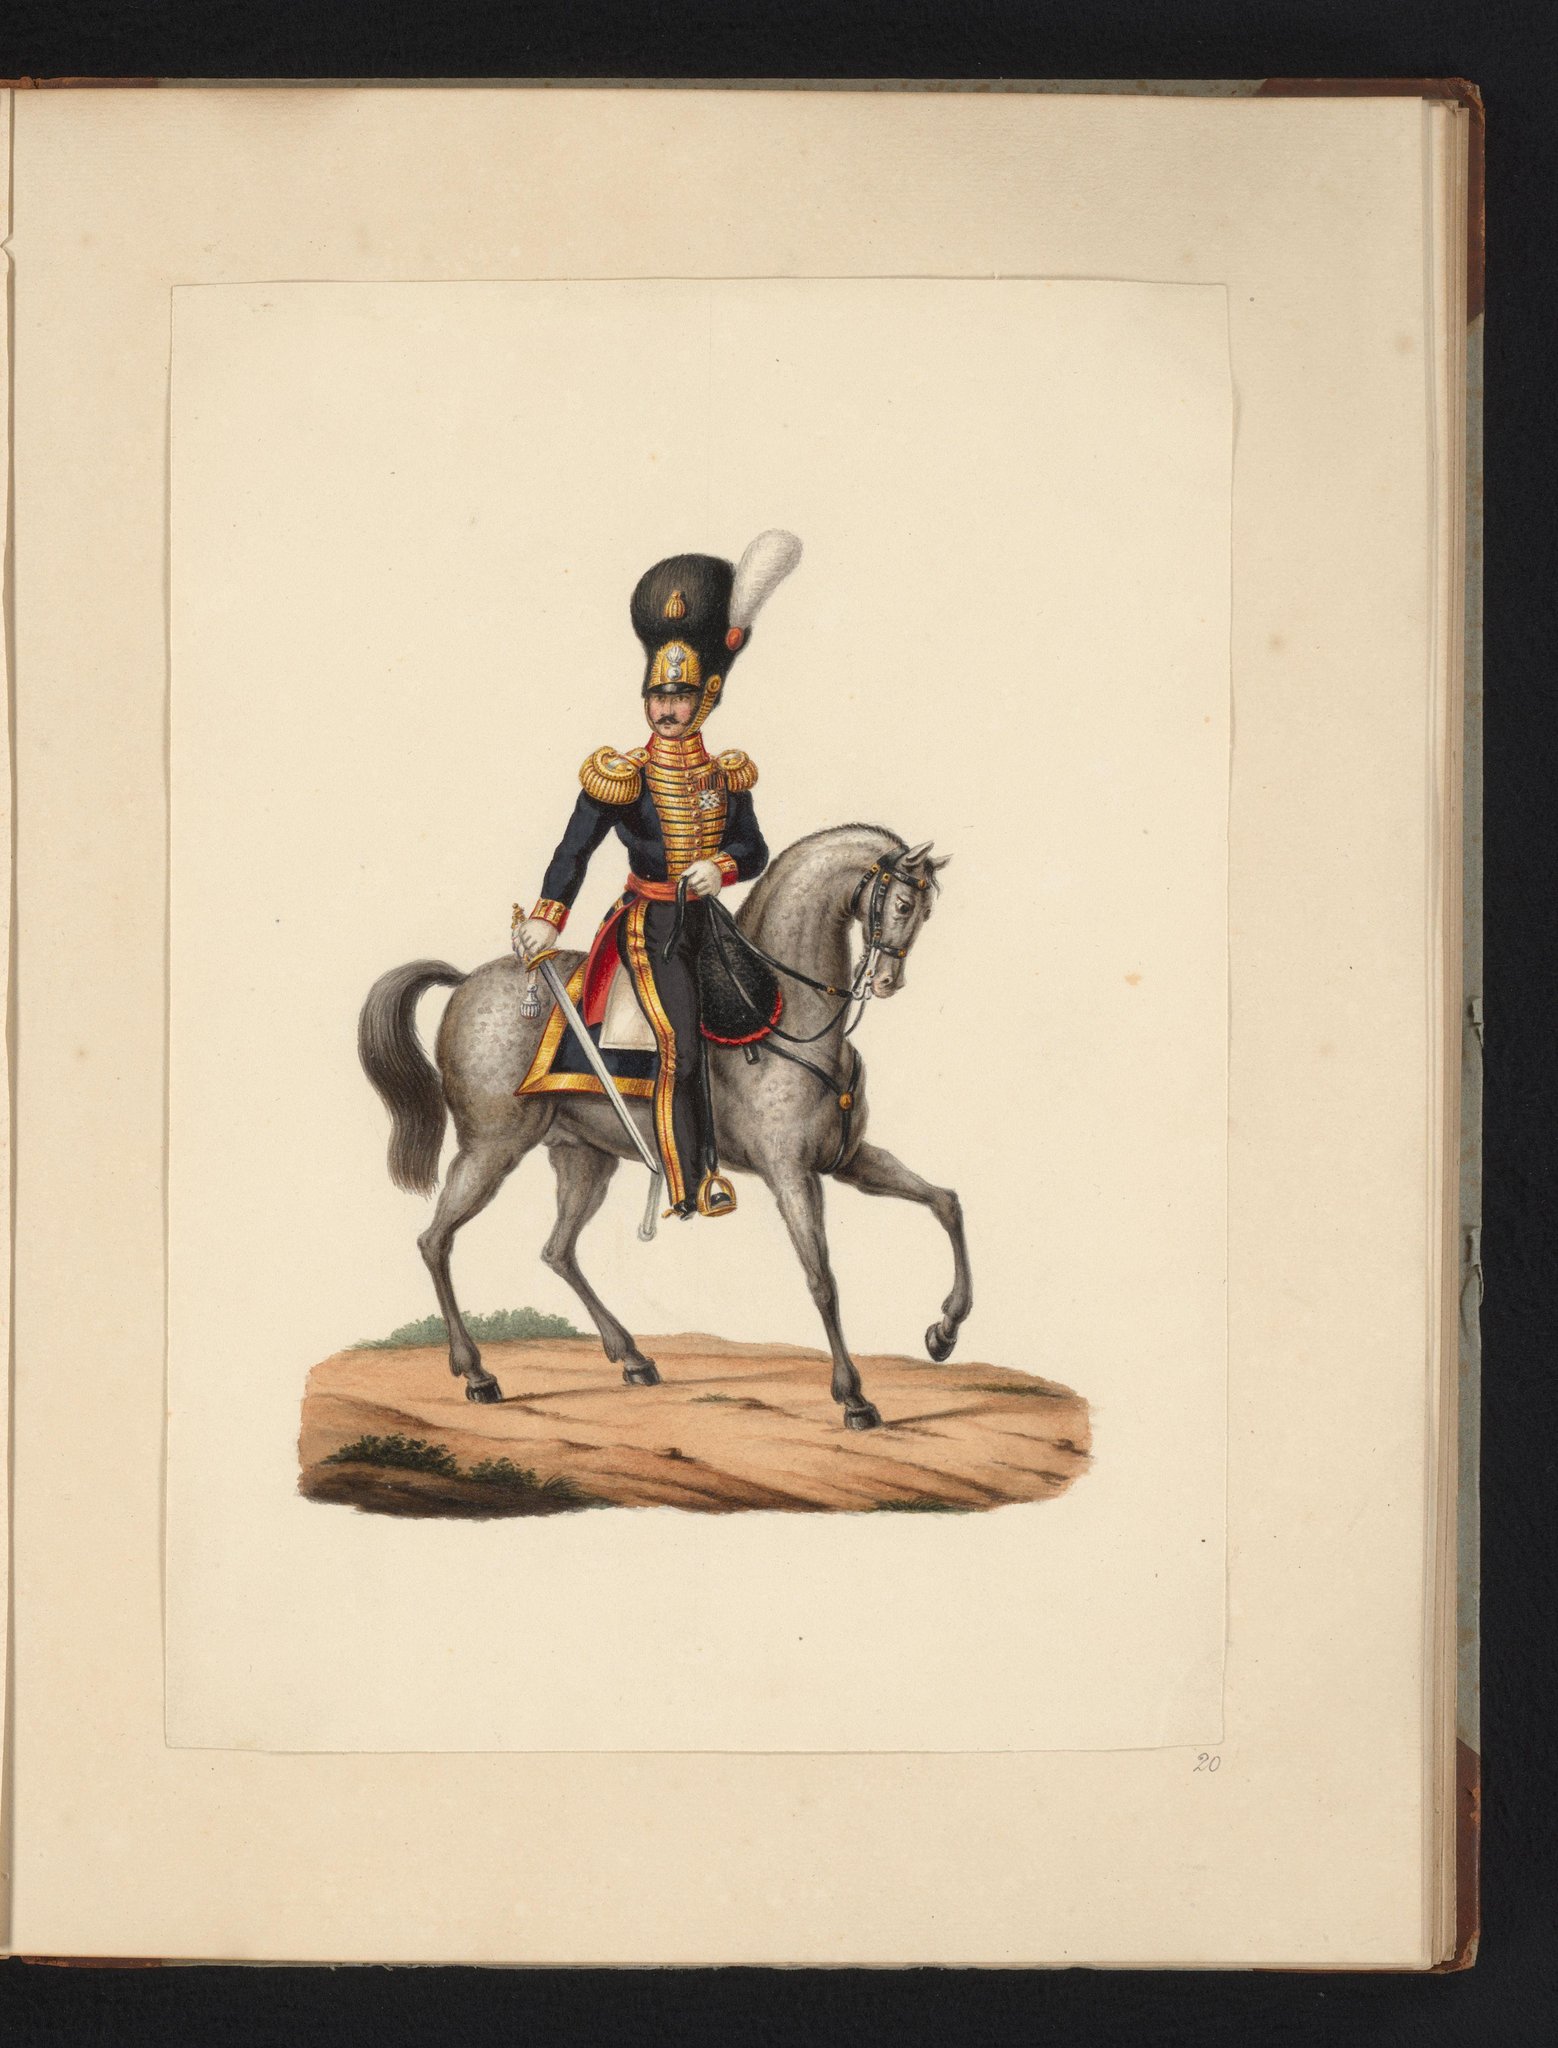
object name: drawing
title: Luitenant-kolonel van de grenadiers, 1830-1831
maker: Anonymous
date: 1831-1832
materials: paper, pencil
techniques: brush, lacquer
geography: netherlands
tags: professional clothes, (military) uniforms, netherlands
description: Een luitenant-kolonel van de grenadiers, te paard. Onderdeel van het album met 39 ingeplakte tekeningen van militairen van de Koninklijke Nederlandsche Armee uit 1830-1831.